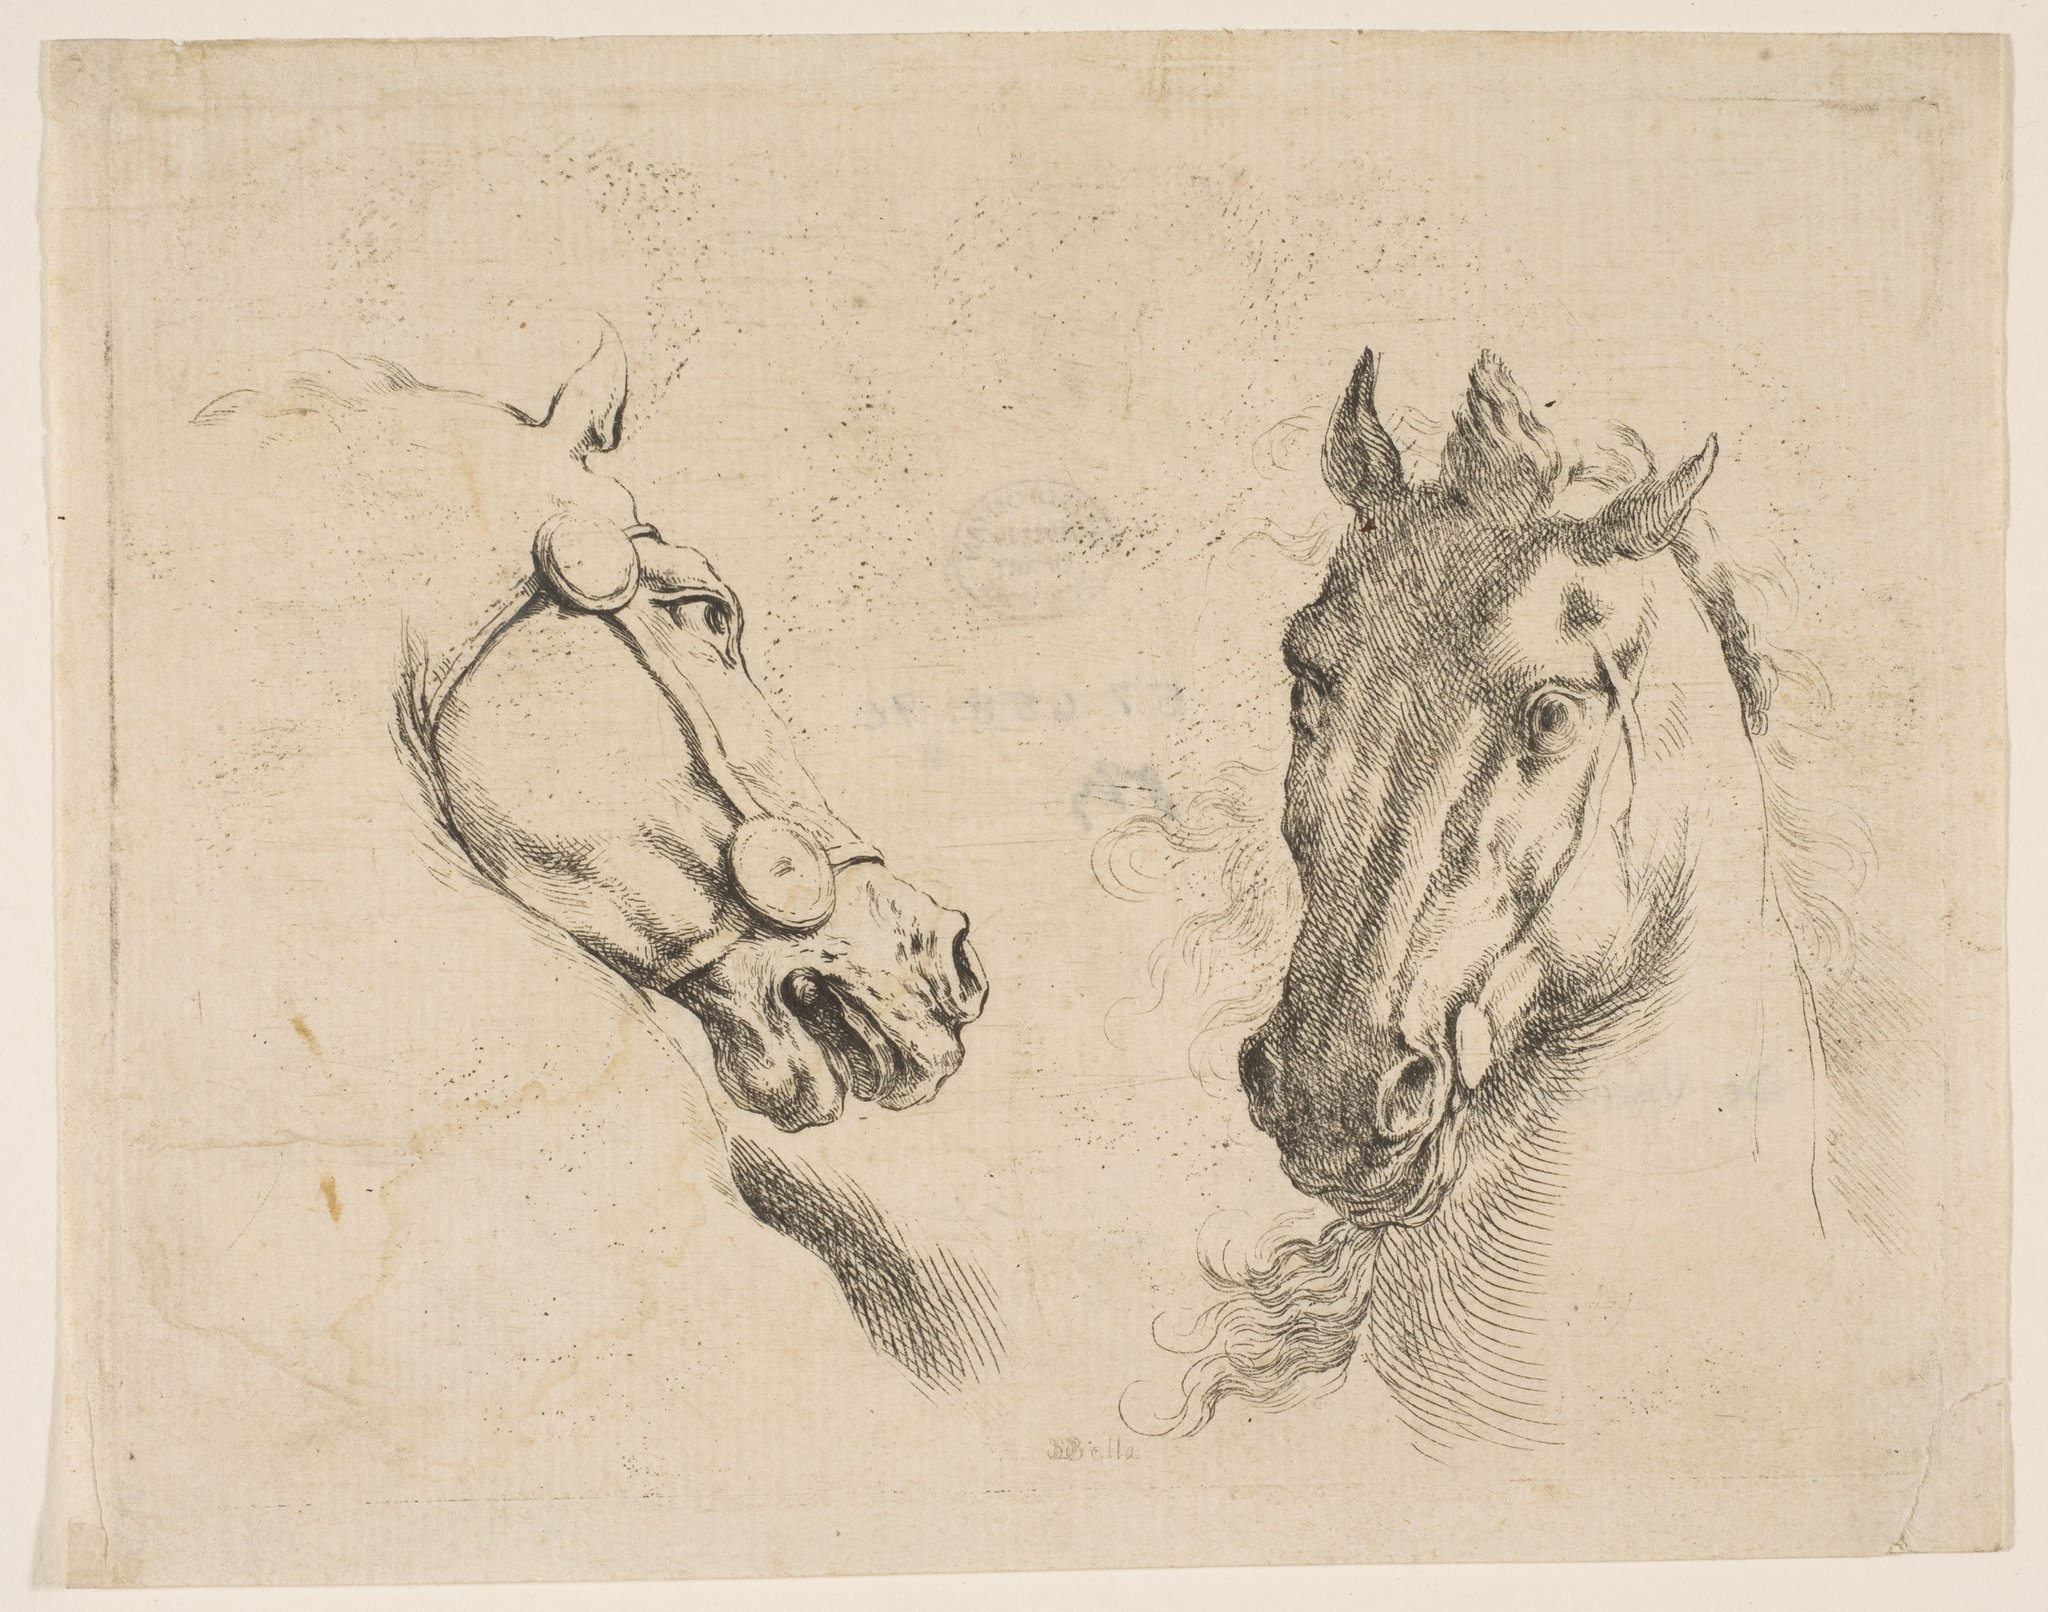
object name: print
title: Two Horse Heads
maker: stefano della bella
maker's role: artist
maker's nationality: italian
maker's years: 1610-1664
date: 1649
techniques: etching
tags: horses